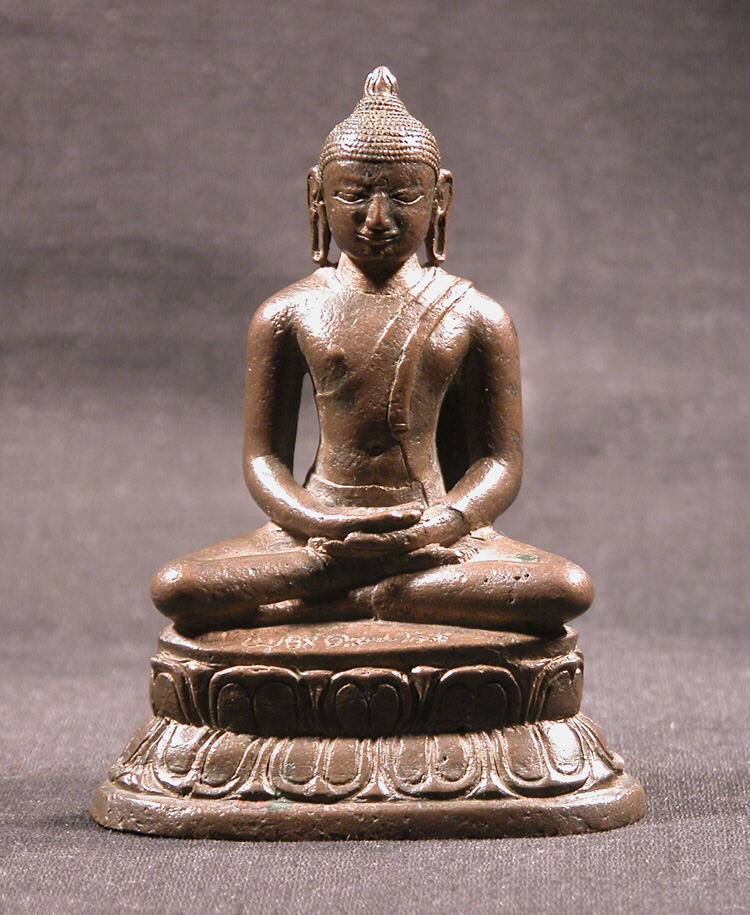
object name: figurine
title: Seated Buddha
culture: indian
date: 1101-1200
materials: copper alloy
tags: later andhra,buddhism,buddha